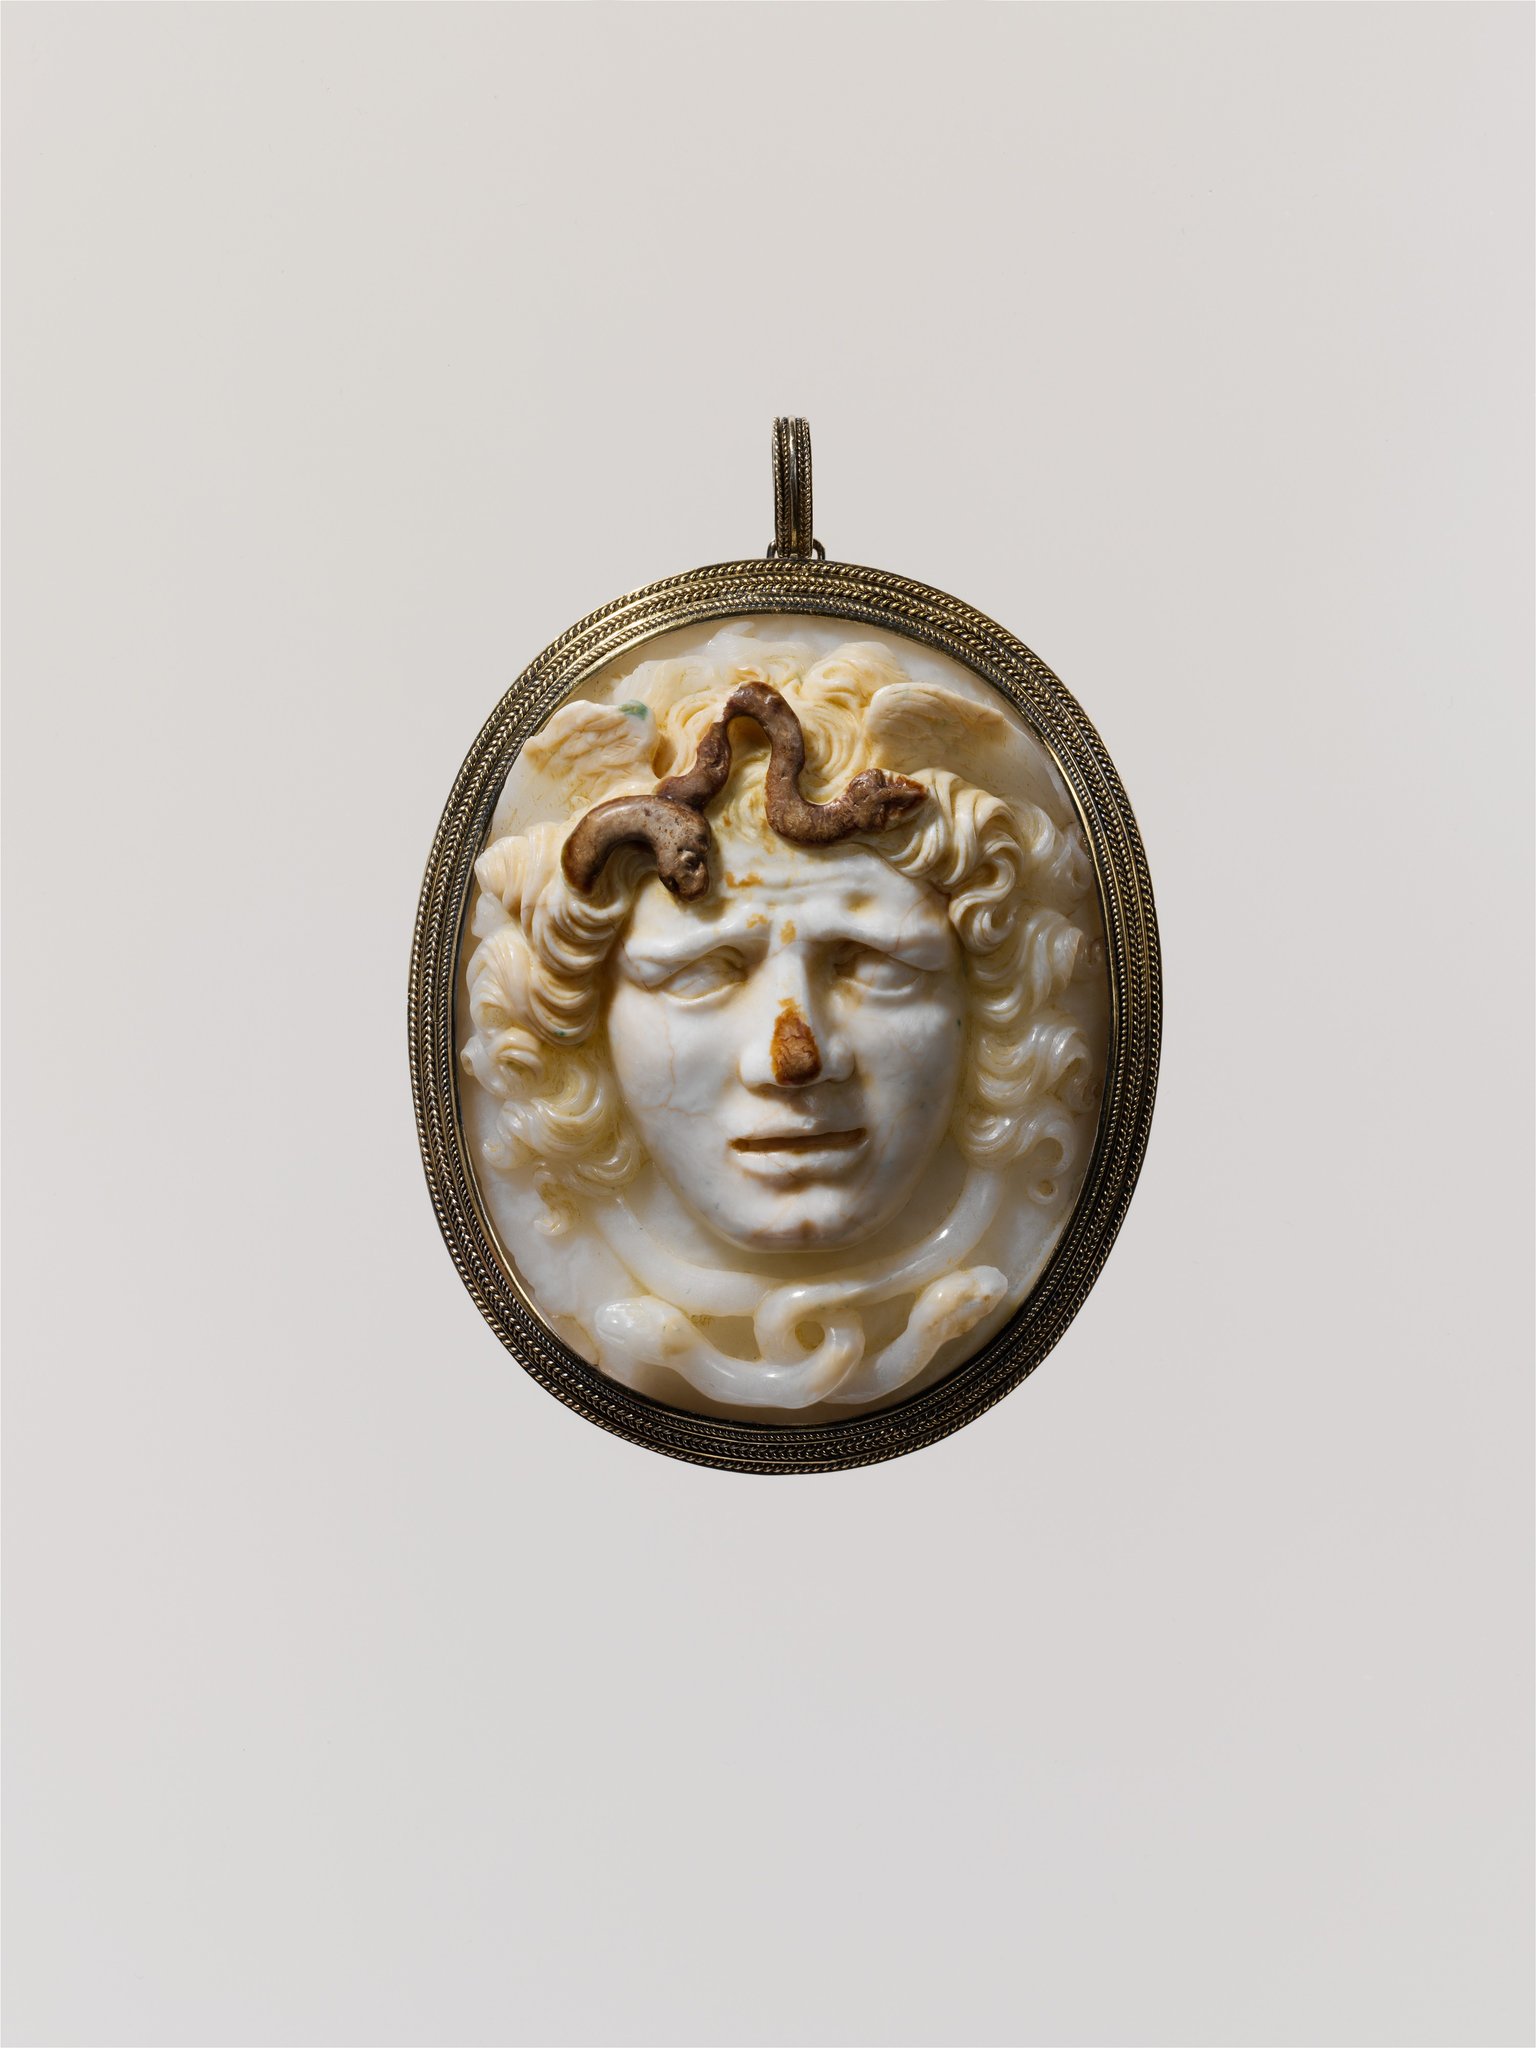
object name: cameo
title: Head of Medusa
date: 1701-1733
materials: gemstone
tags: medusa,snakes